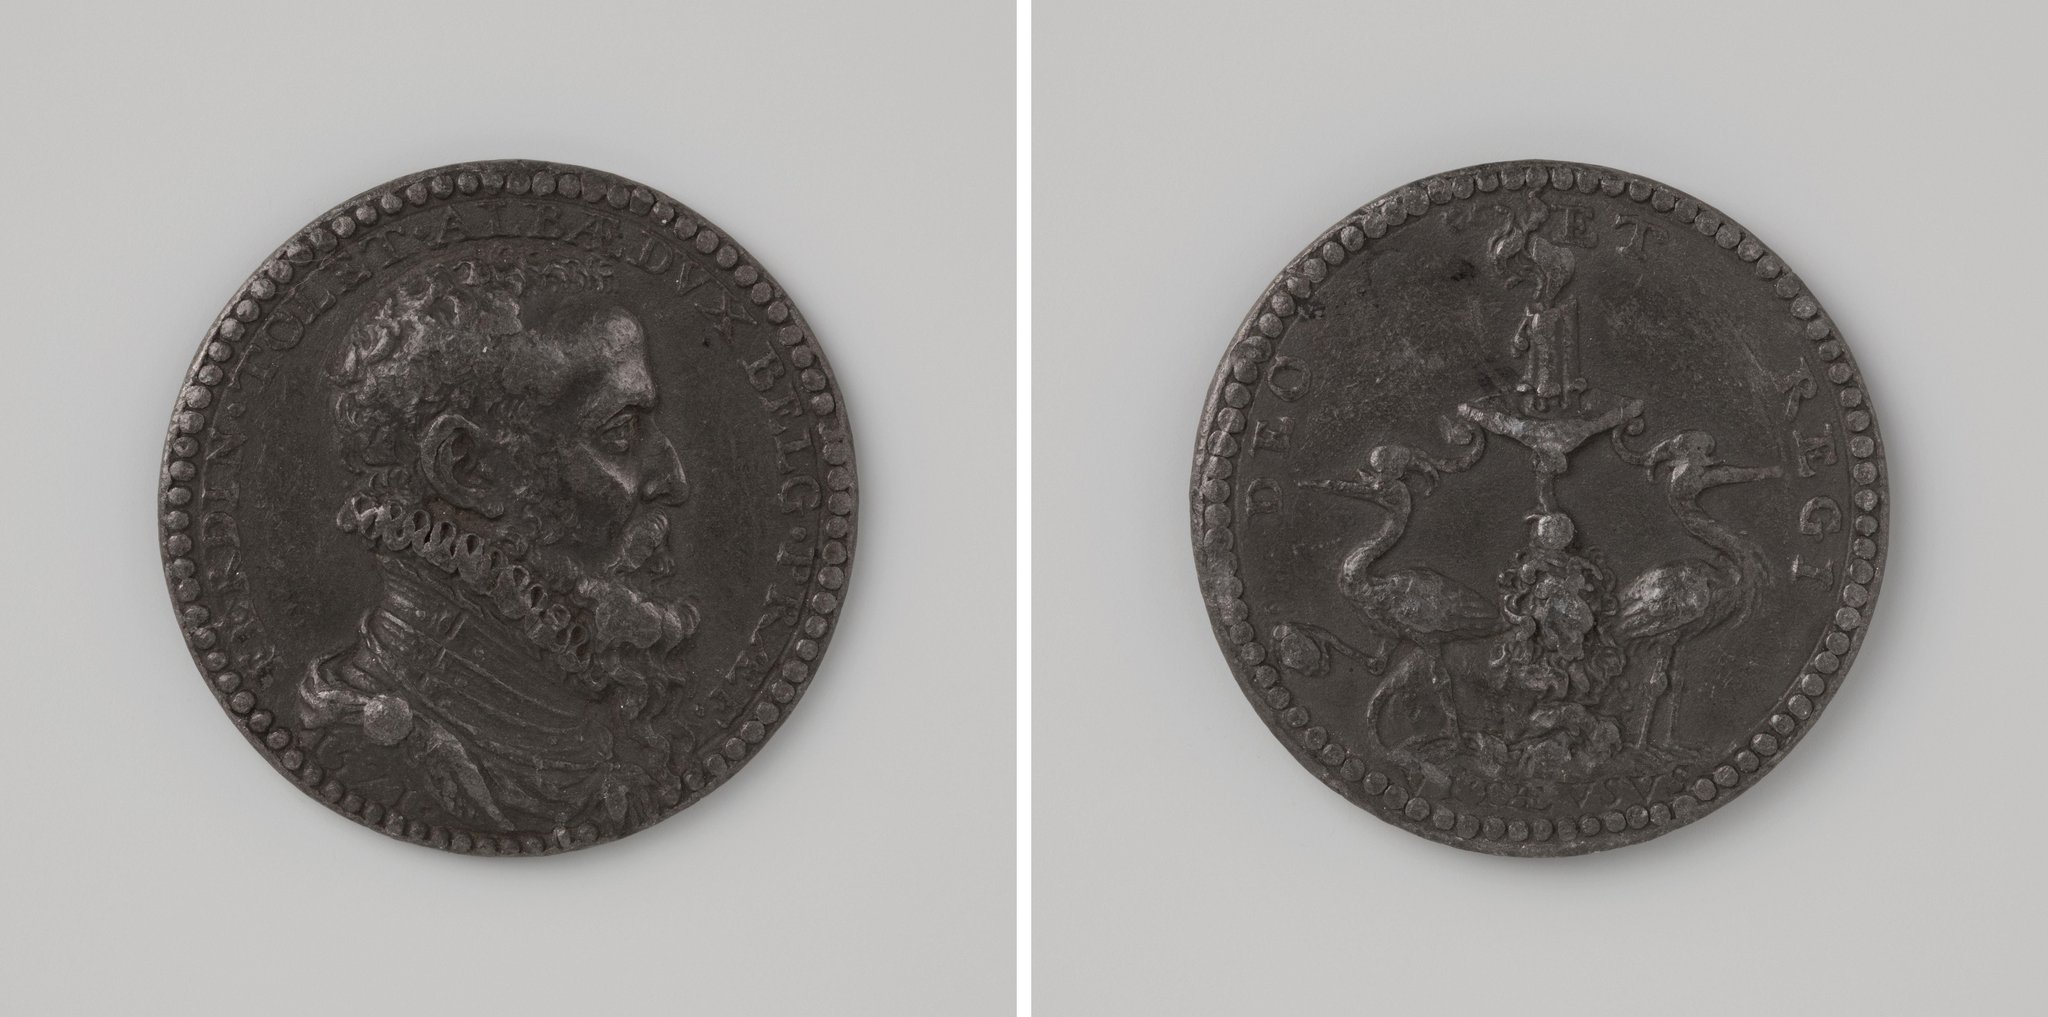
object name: history medal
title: Ferdinand van Toledo hertog van Alva 1571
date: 1571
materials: tin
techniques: casting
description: Tinnen penning, op de voorzijde het portret van Alva naar rechts, met omschrift, op de keerzijde een brandende kandelaar gedragen door een leeuw en twee kraanvogels, met omschrift